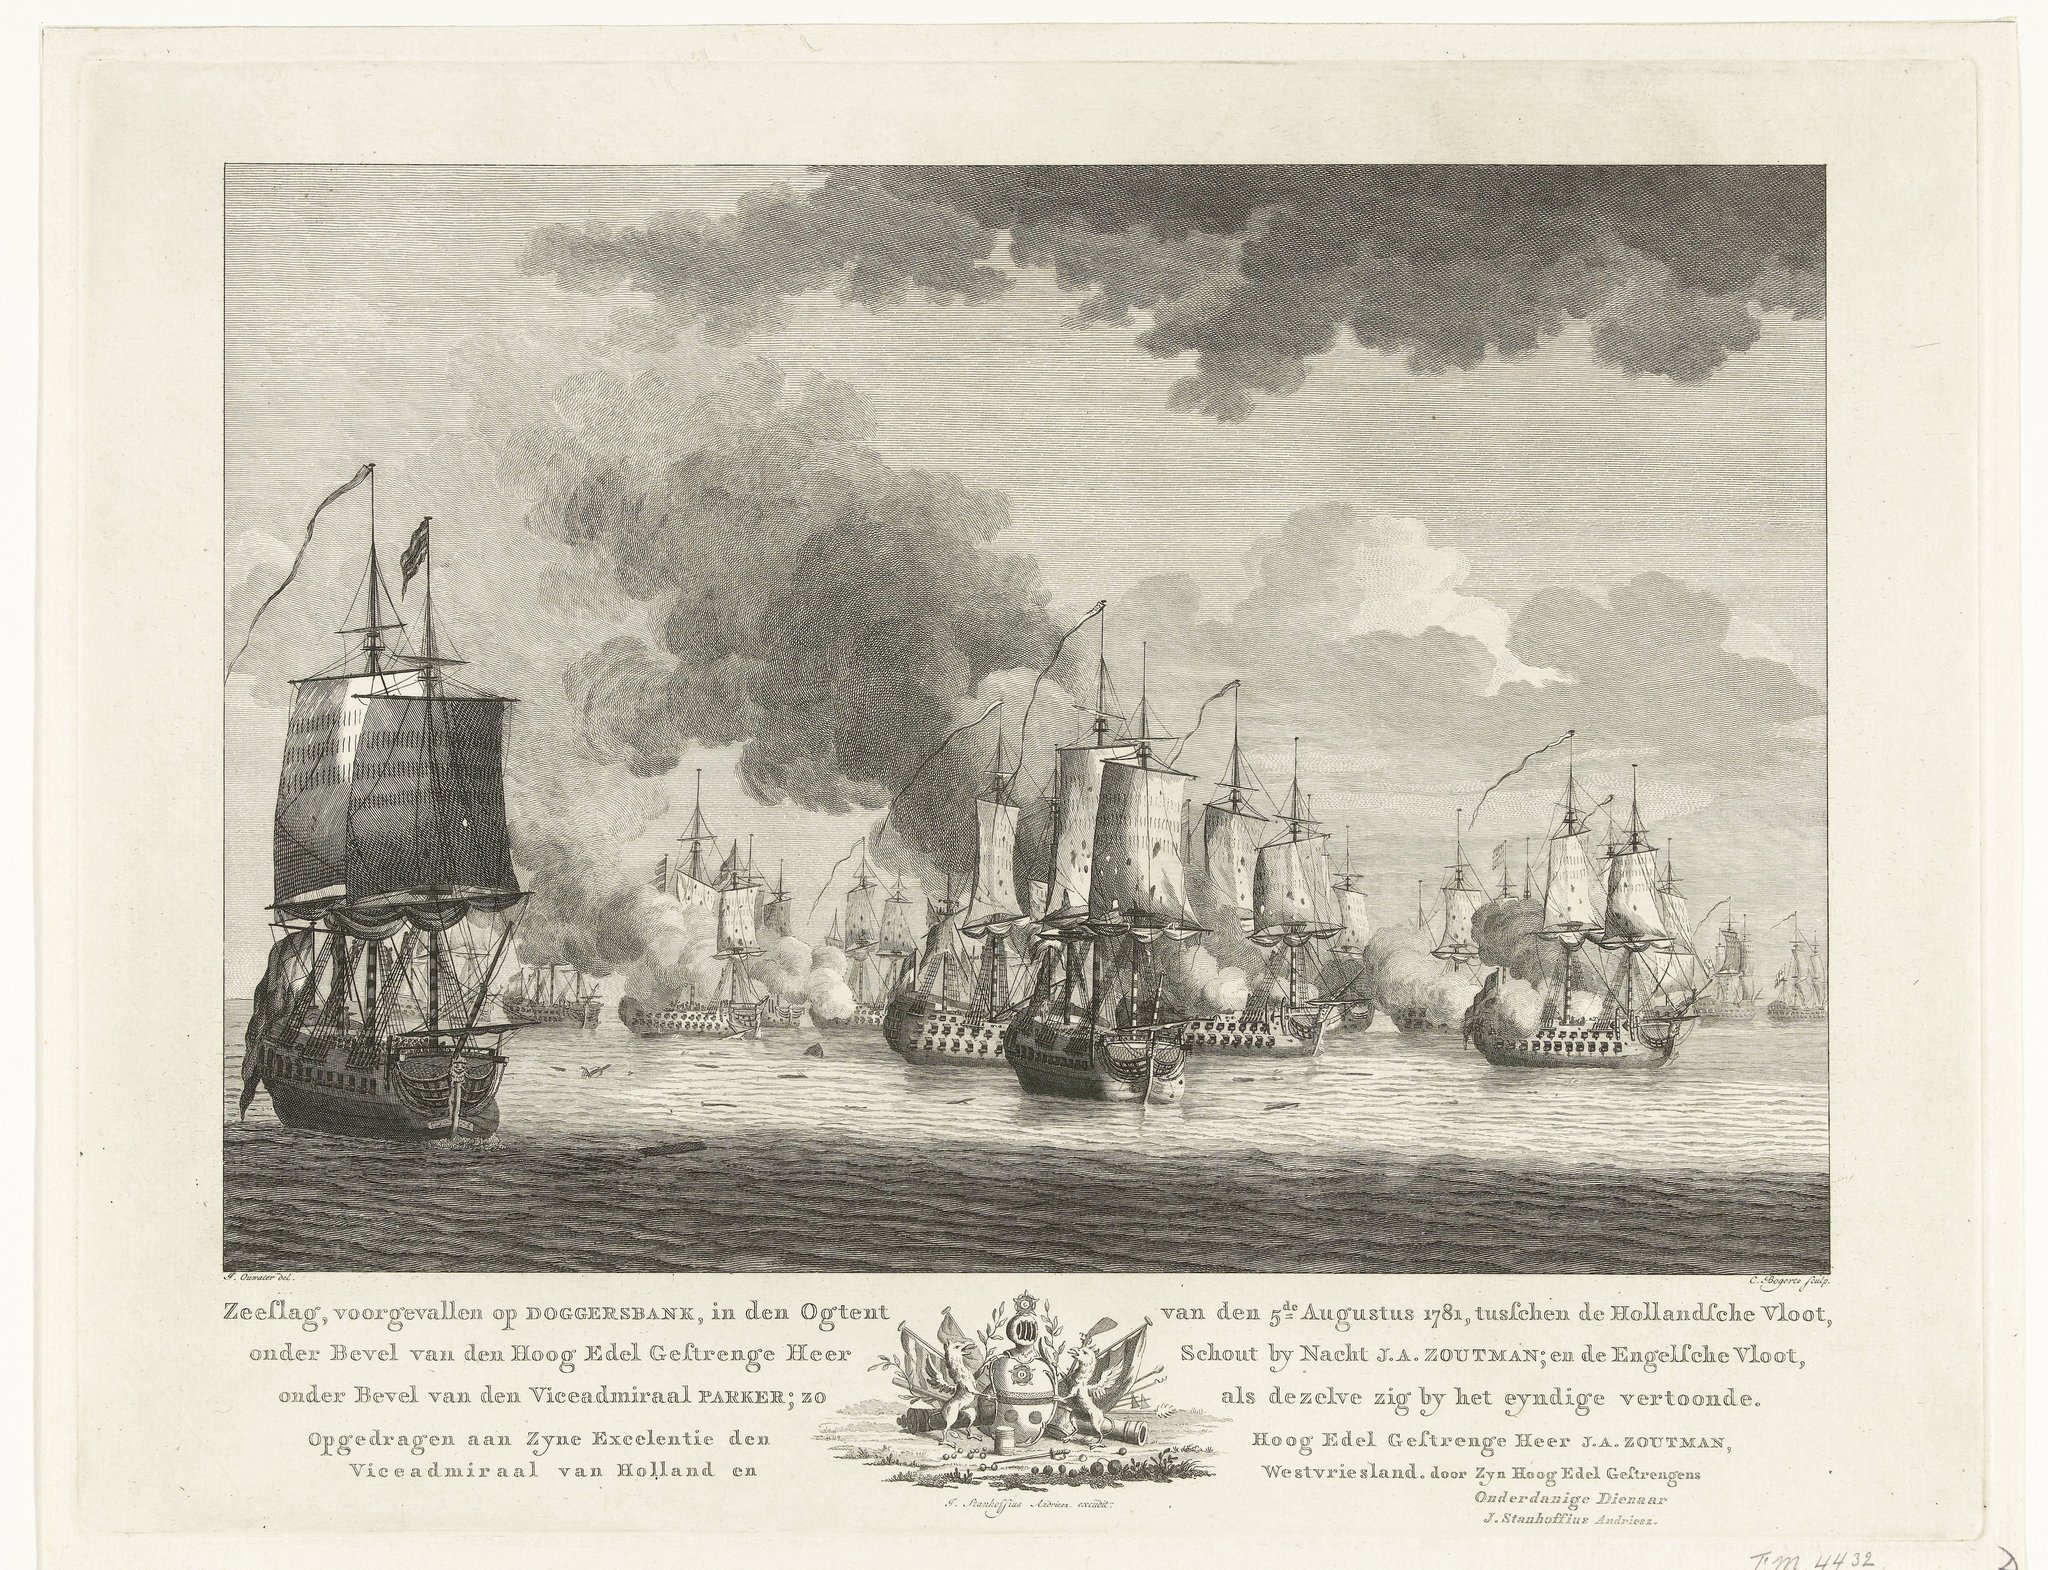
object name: print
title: Zeeslag bij Doggersbank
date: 1781-1783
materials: paper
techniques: etching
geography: amsterdam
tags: zeeslag bij doggersbank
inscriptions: collector's mark: Lugt 2228